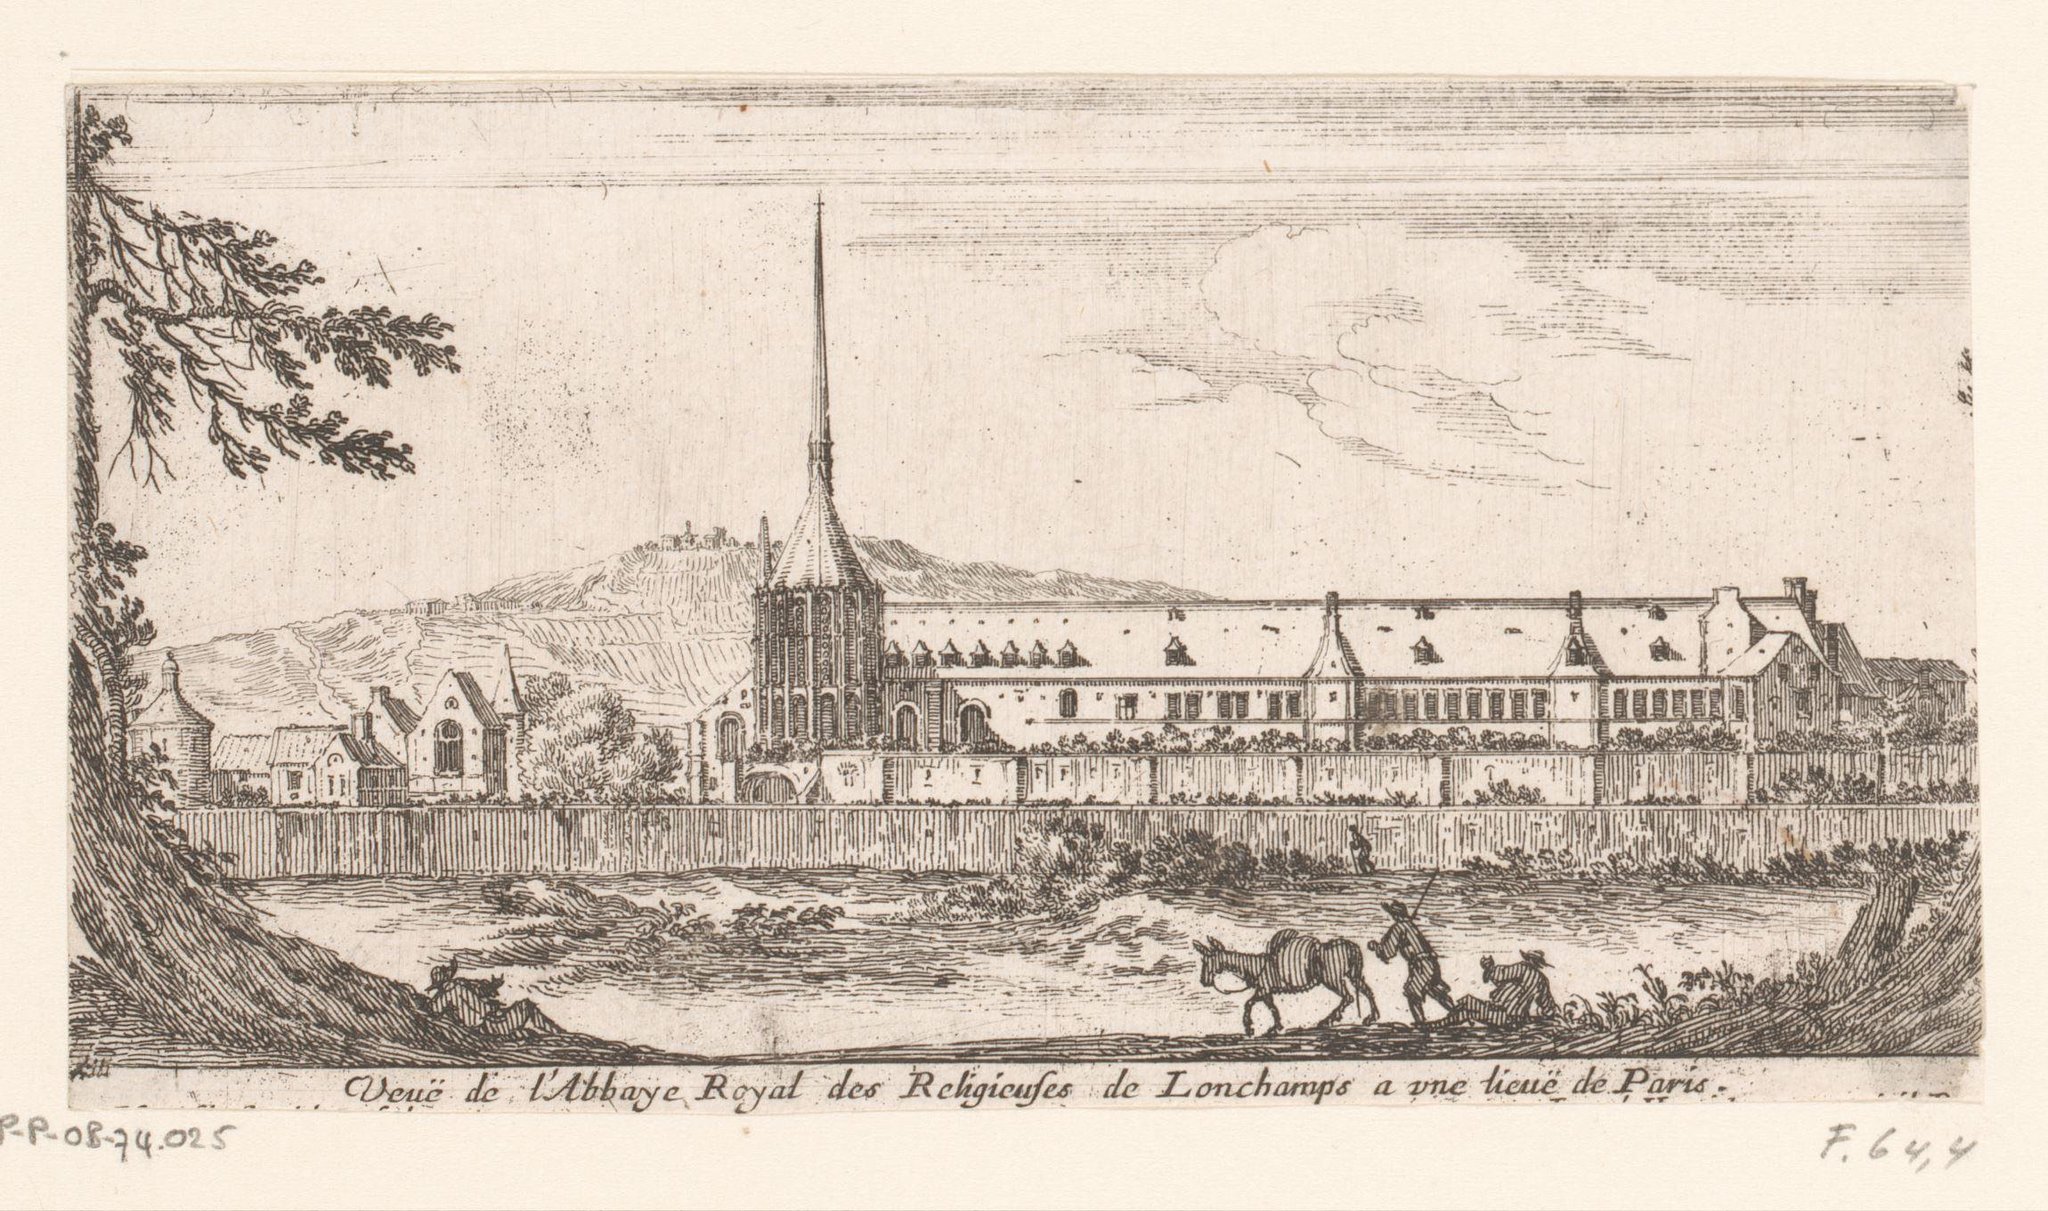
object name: print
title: Veue de l'Abbaye Royal des Religieuses de Lonchamps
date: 1652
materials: paper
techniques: engraving, etching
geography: france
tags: landscape with tower or castle, paris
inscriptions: collector's mark: Lugt 240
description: Prent maakt deel uit van een ongenummerde serie van 30 prenten.